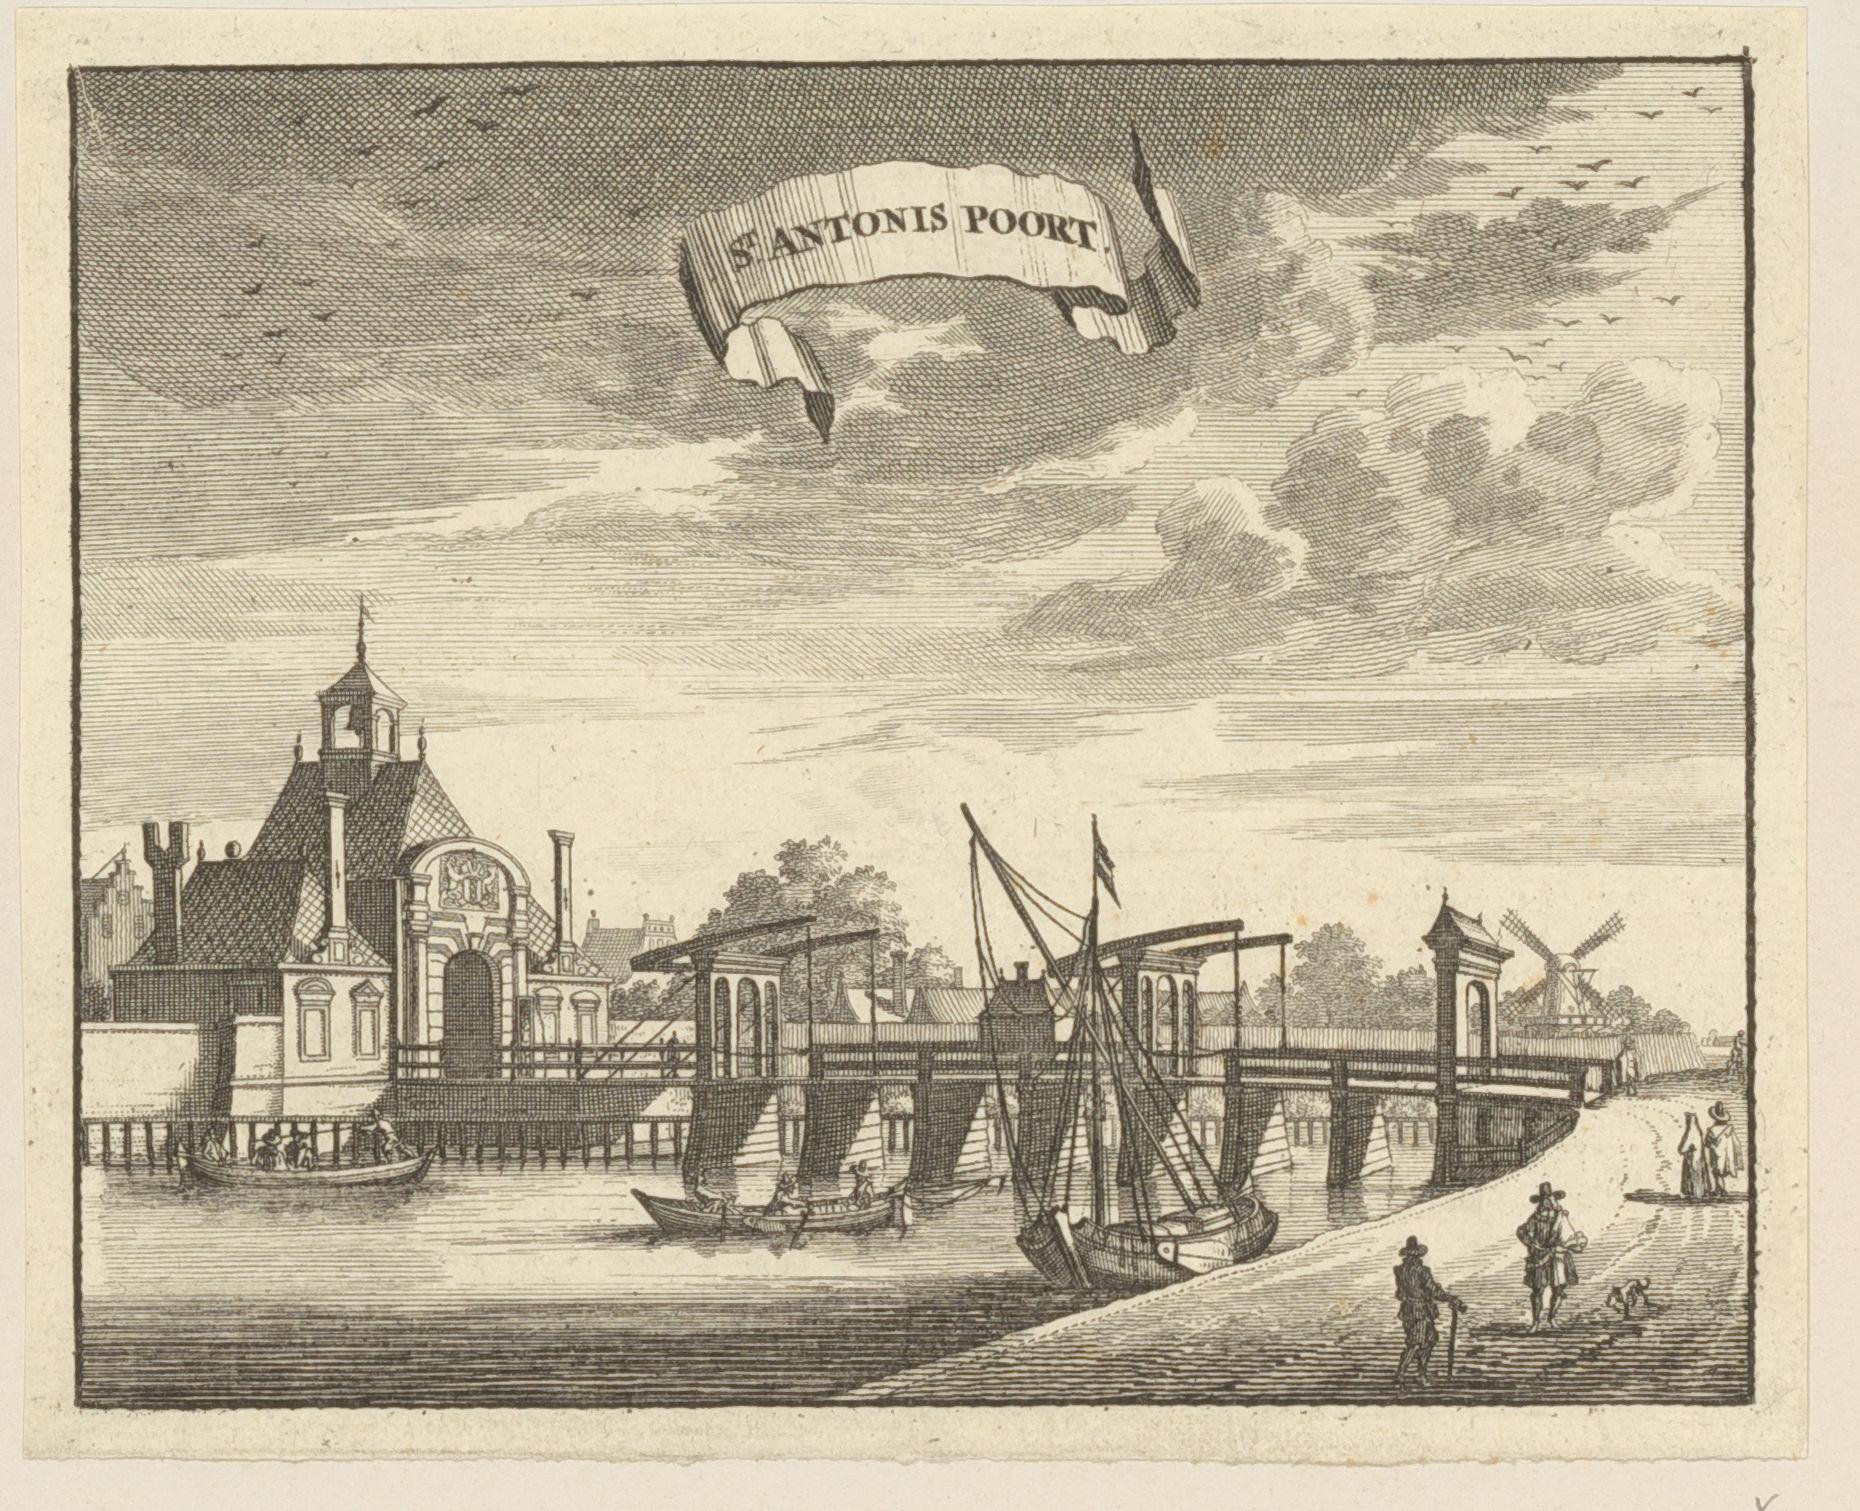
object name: print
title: St. Antonis Poort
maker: Anonymous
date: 1724-1726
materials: paper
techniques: engraving, etching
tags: canal, bridge, city-gate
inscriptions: stamp, collector's mark: Lugt 1641, stamp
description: Prent mogelijk uit: Commelin, Caspar. Beschryvinge van Amsterdam, zynde een naukeurige verhandelinge van desselfs eerste oorspronk uyt (…). 2 dln. 2de druk. Amsterdam: Andries van Damme et al., 1726.